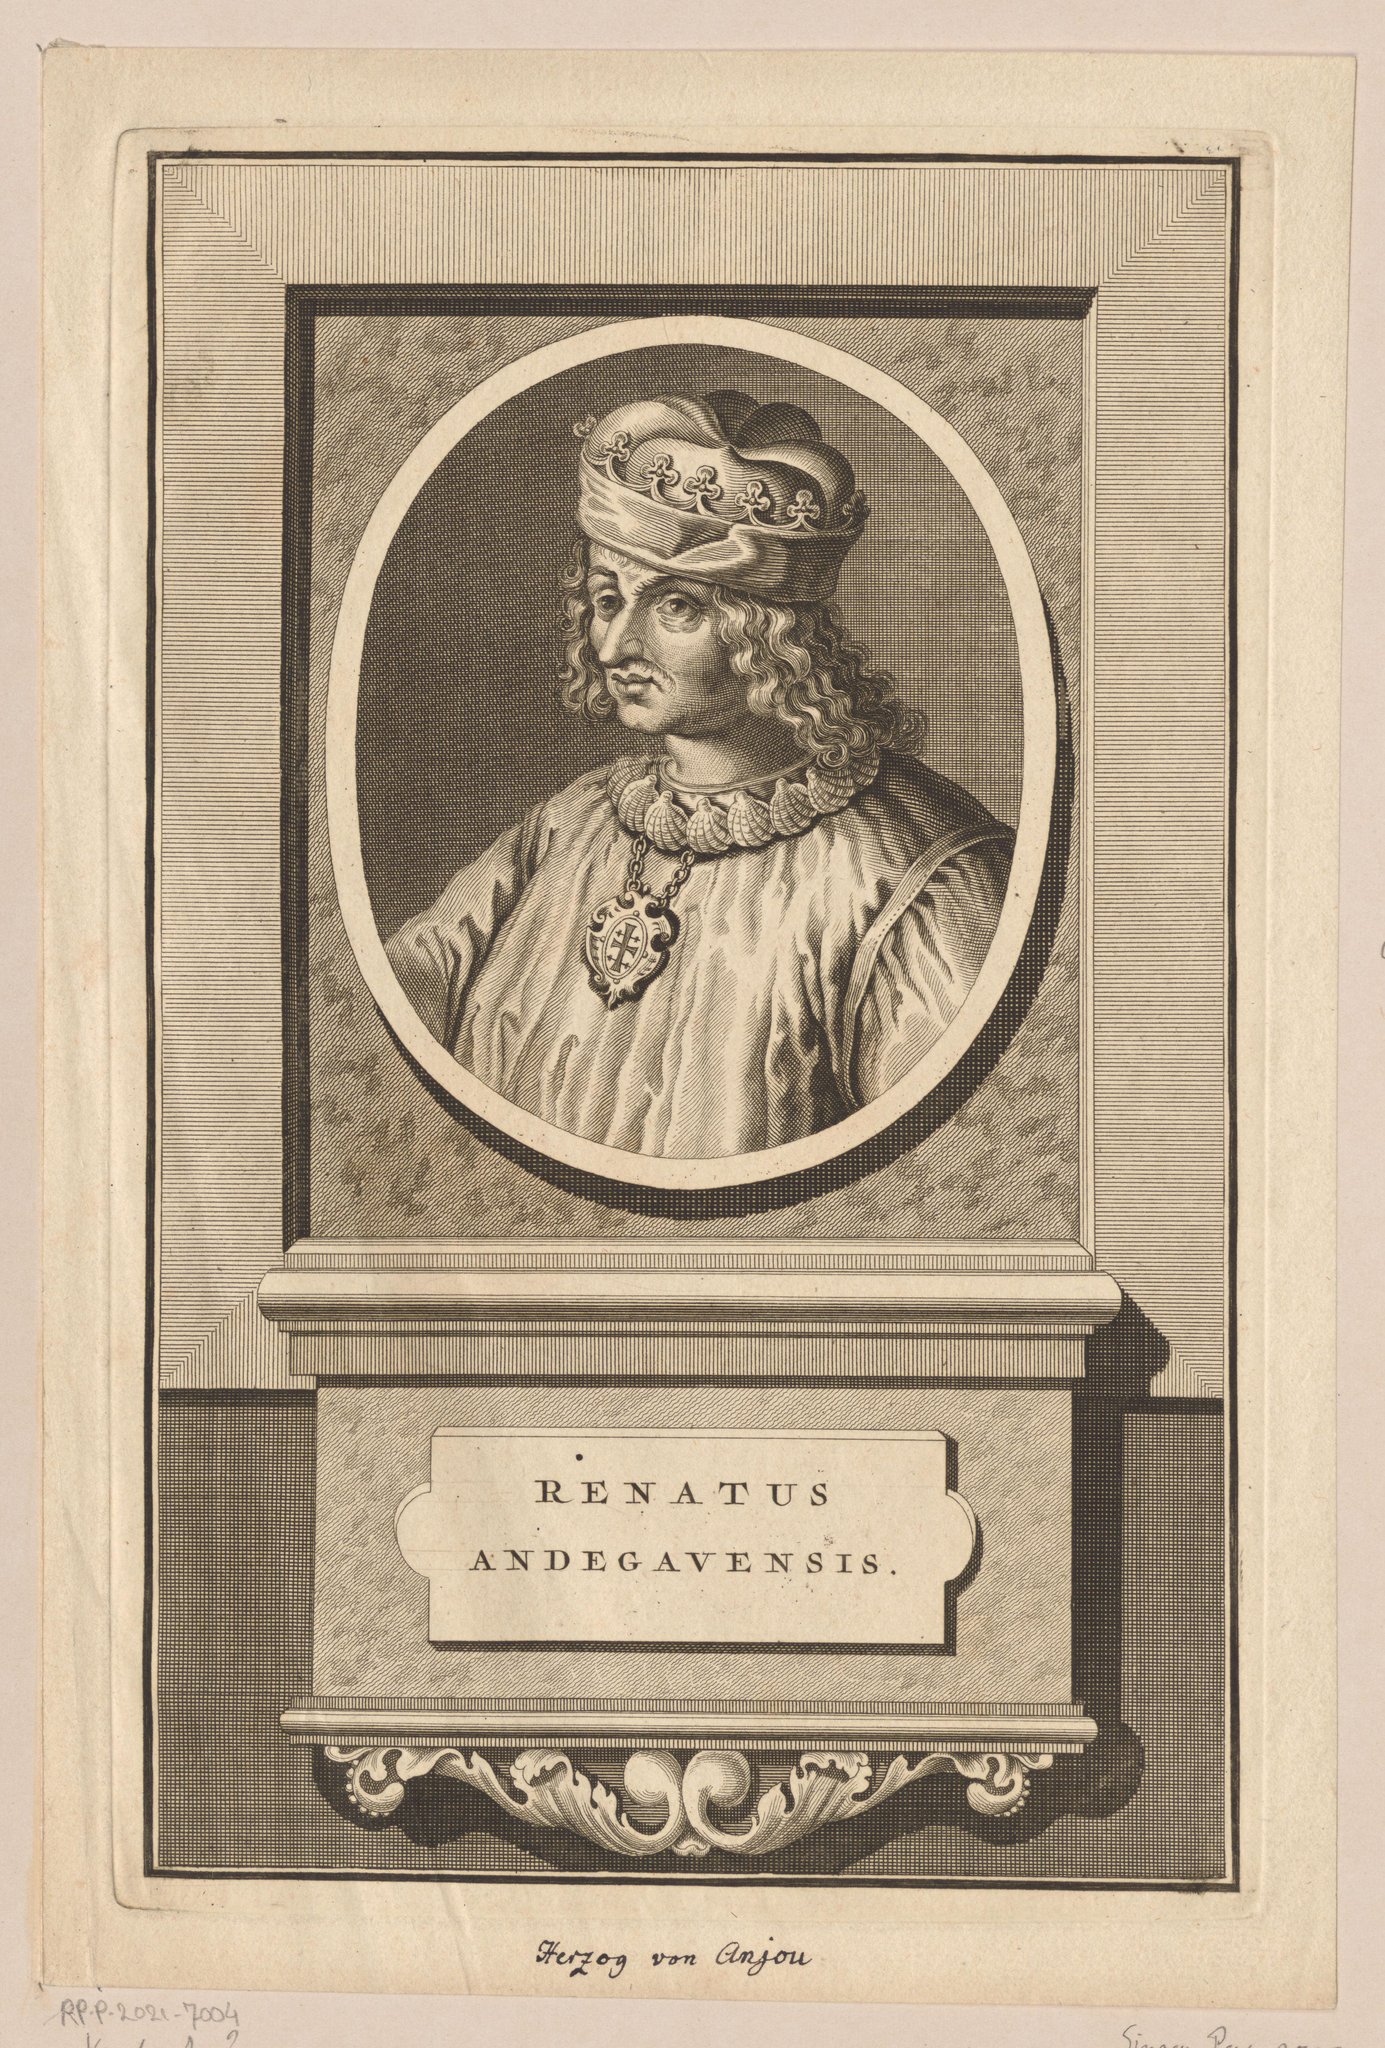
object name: print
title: Portret van René I van Anjou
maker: Anonymous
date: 1700-1749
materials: paper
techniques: engraving, etching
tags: rené i van anjou, crown (symbol of sovereignty), historical persons, king